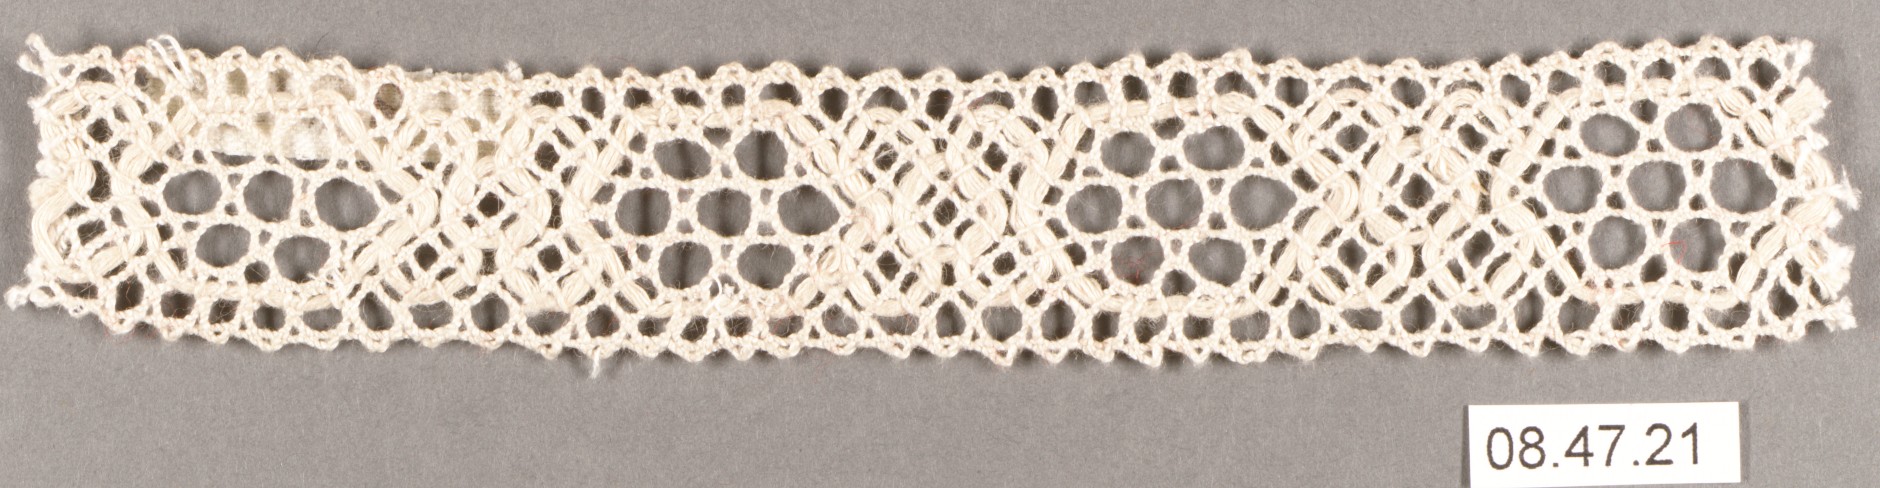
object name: fragment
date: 1801-1900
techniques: lace